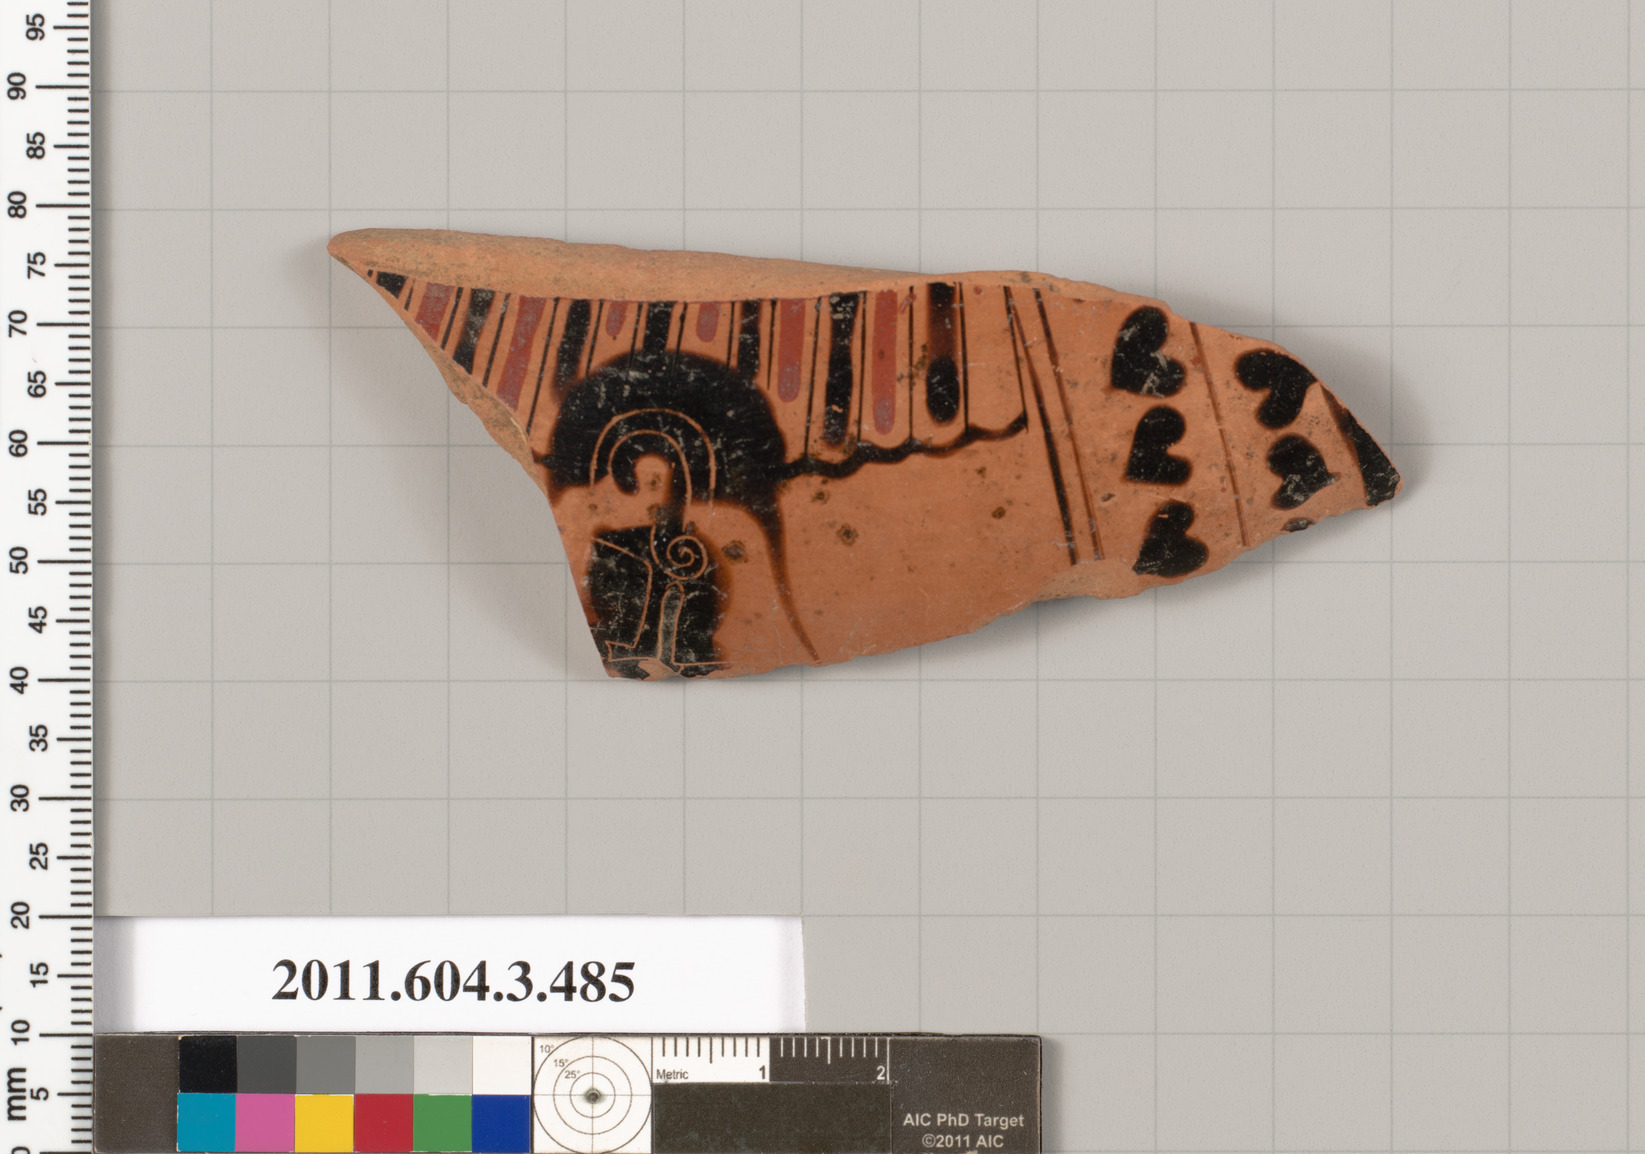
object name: column krater fragment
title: Terracotta fragment of a column-krater (bowl for mixing wine and water)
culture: greek, attic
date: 550-526 BCE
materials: terracotta